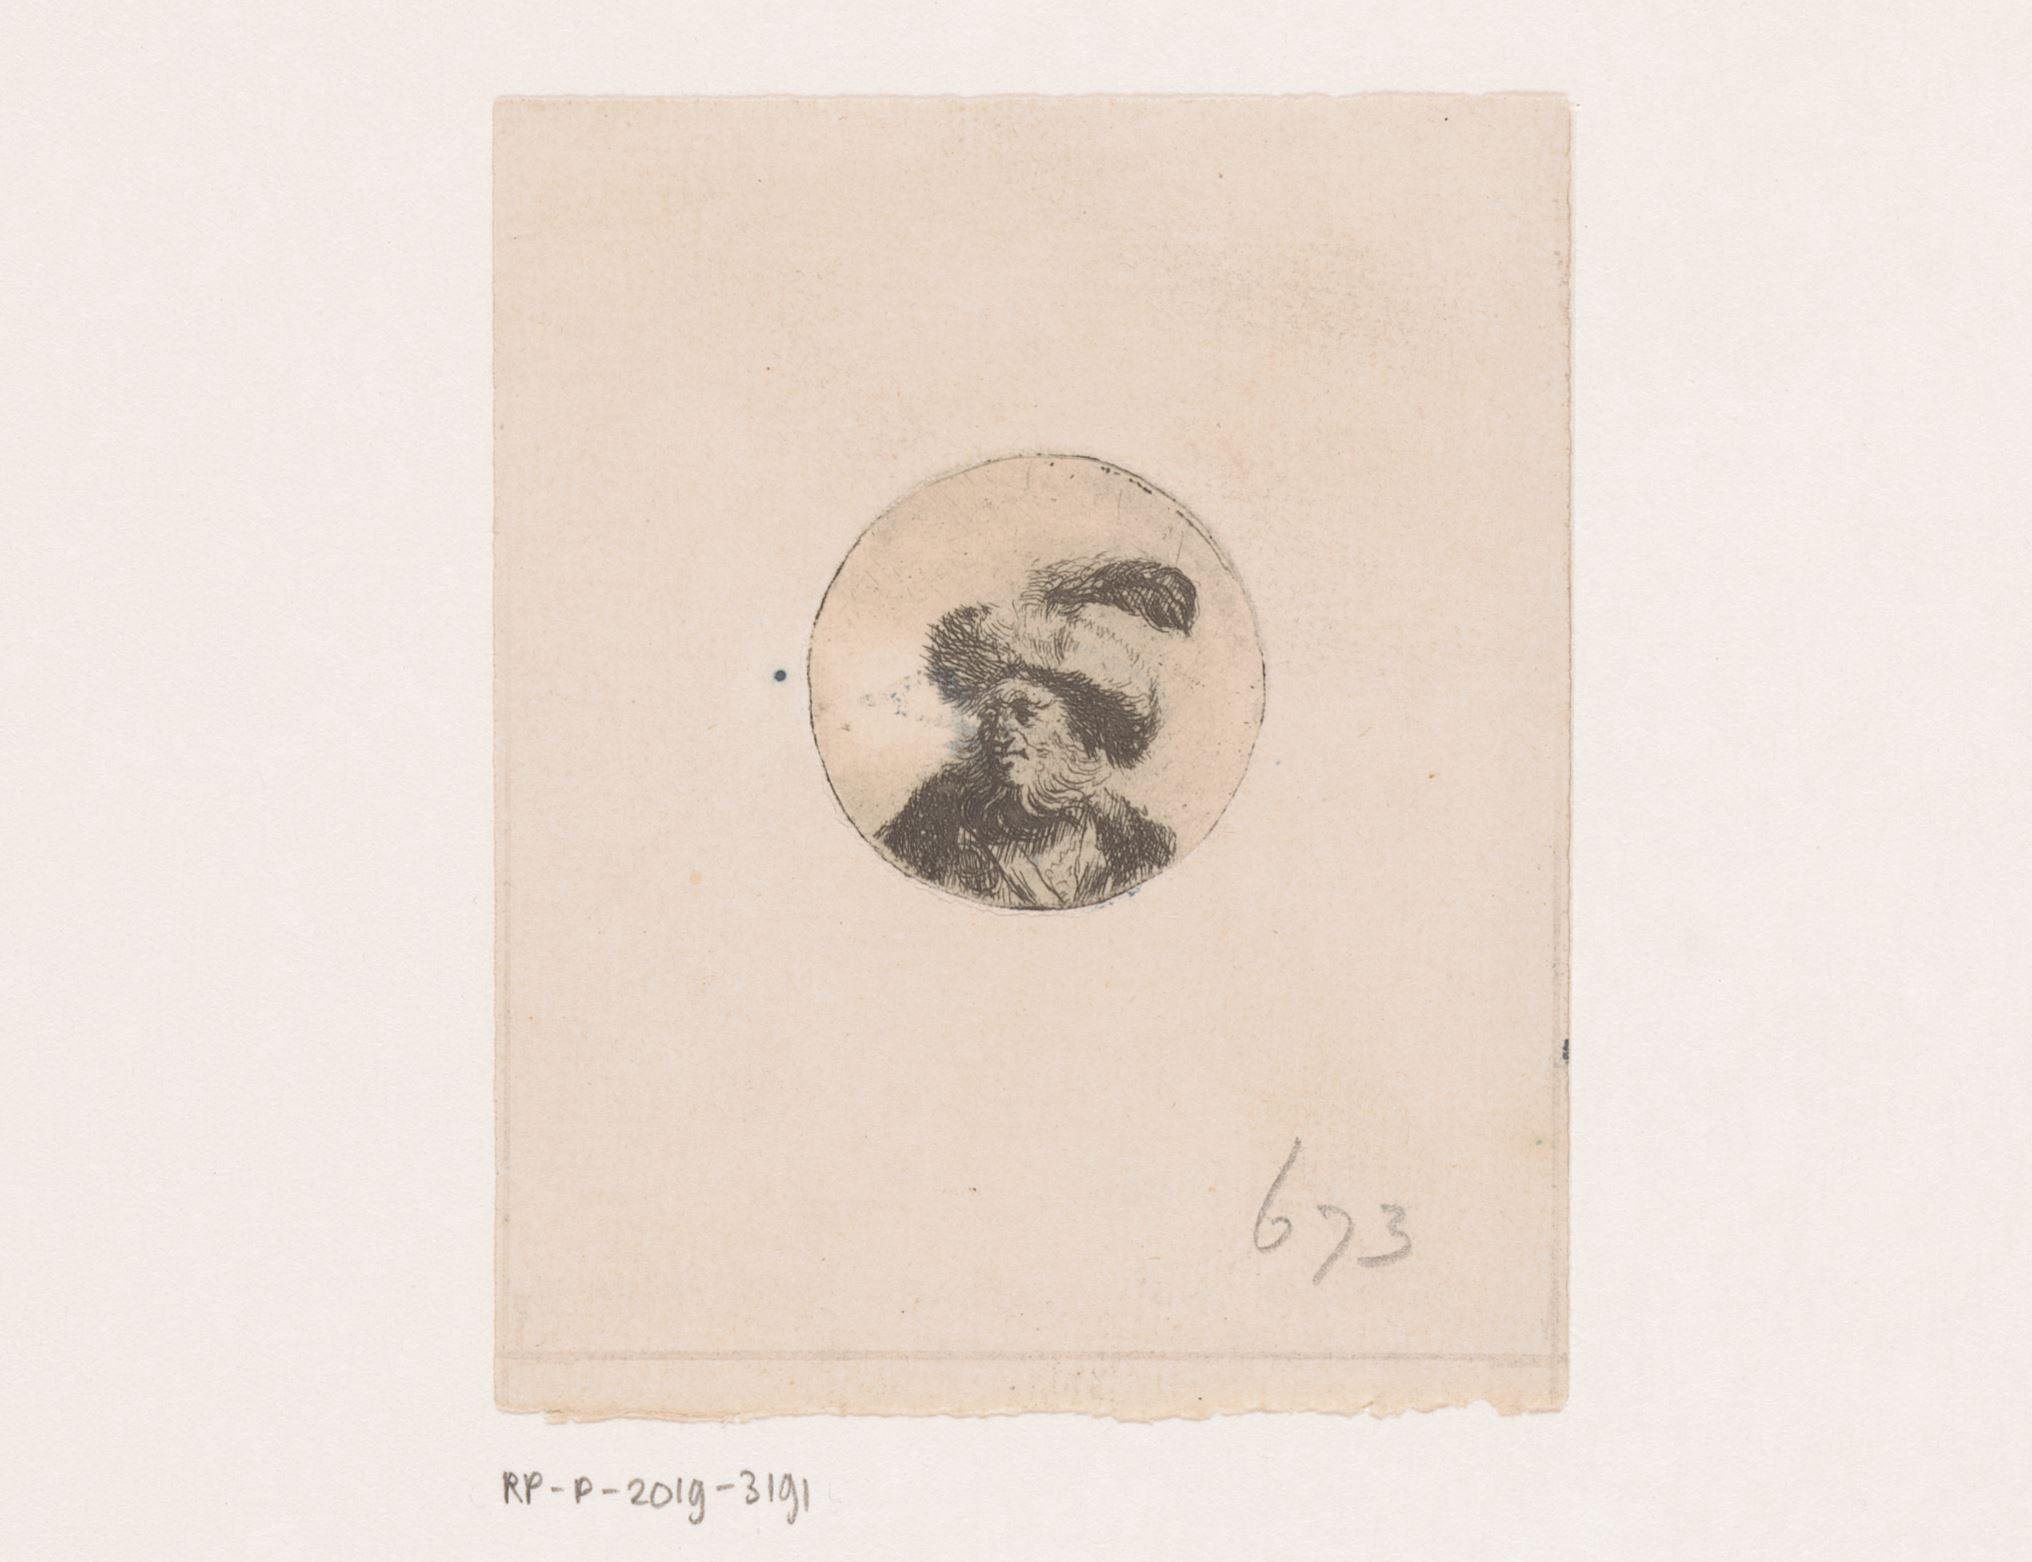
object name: print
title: Buste van een man met bontmuts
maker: Anonymous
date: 1650-1800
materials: paper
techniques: etching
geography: netherlands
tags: head-gear and clothing for the upper part of the body (+ fur used for clothes)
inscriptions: inscription: ‘gedrukt met een plaatje (?) en ten re[...]/ W. Hekking (?) +/- 1894’, collector's mark: Lugt 2228